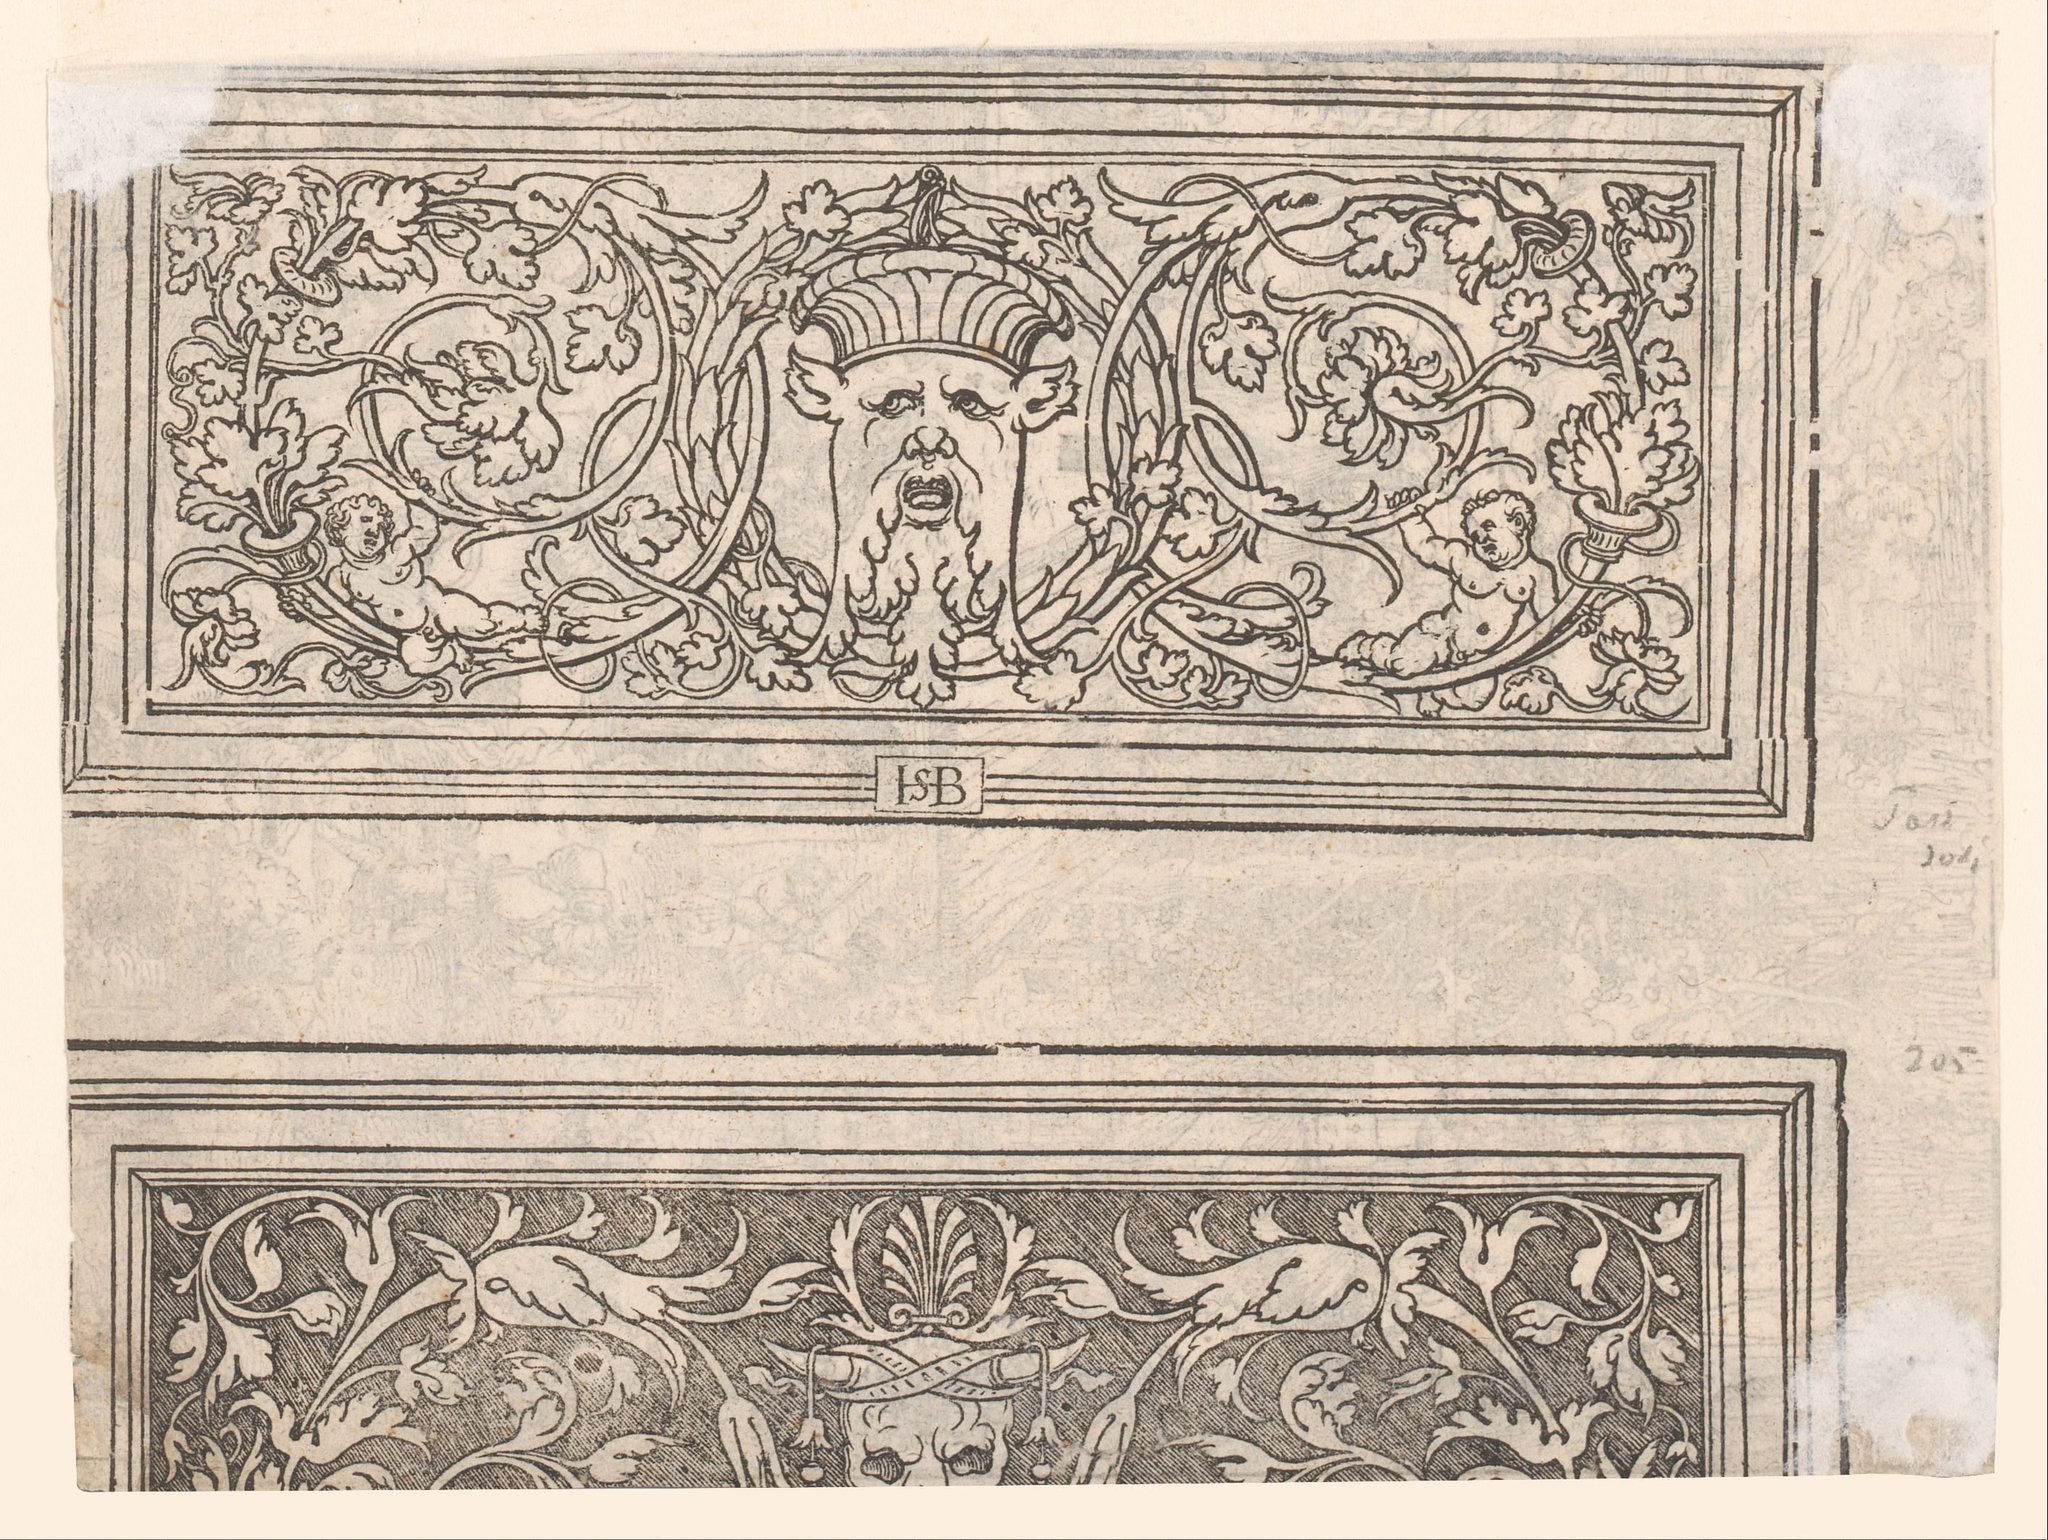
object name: ornament print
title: Ornament met een mascaron en een deel van een ornamentprent met een ossenschedel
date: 1546-1550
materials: paper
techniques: woodcut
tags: ornaments ~ art, mask, mascaron ~ ornament